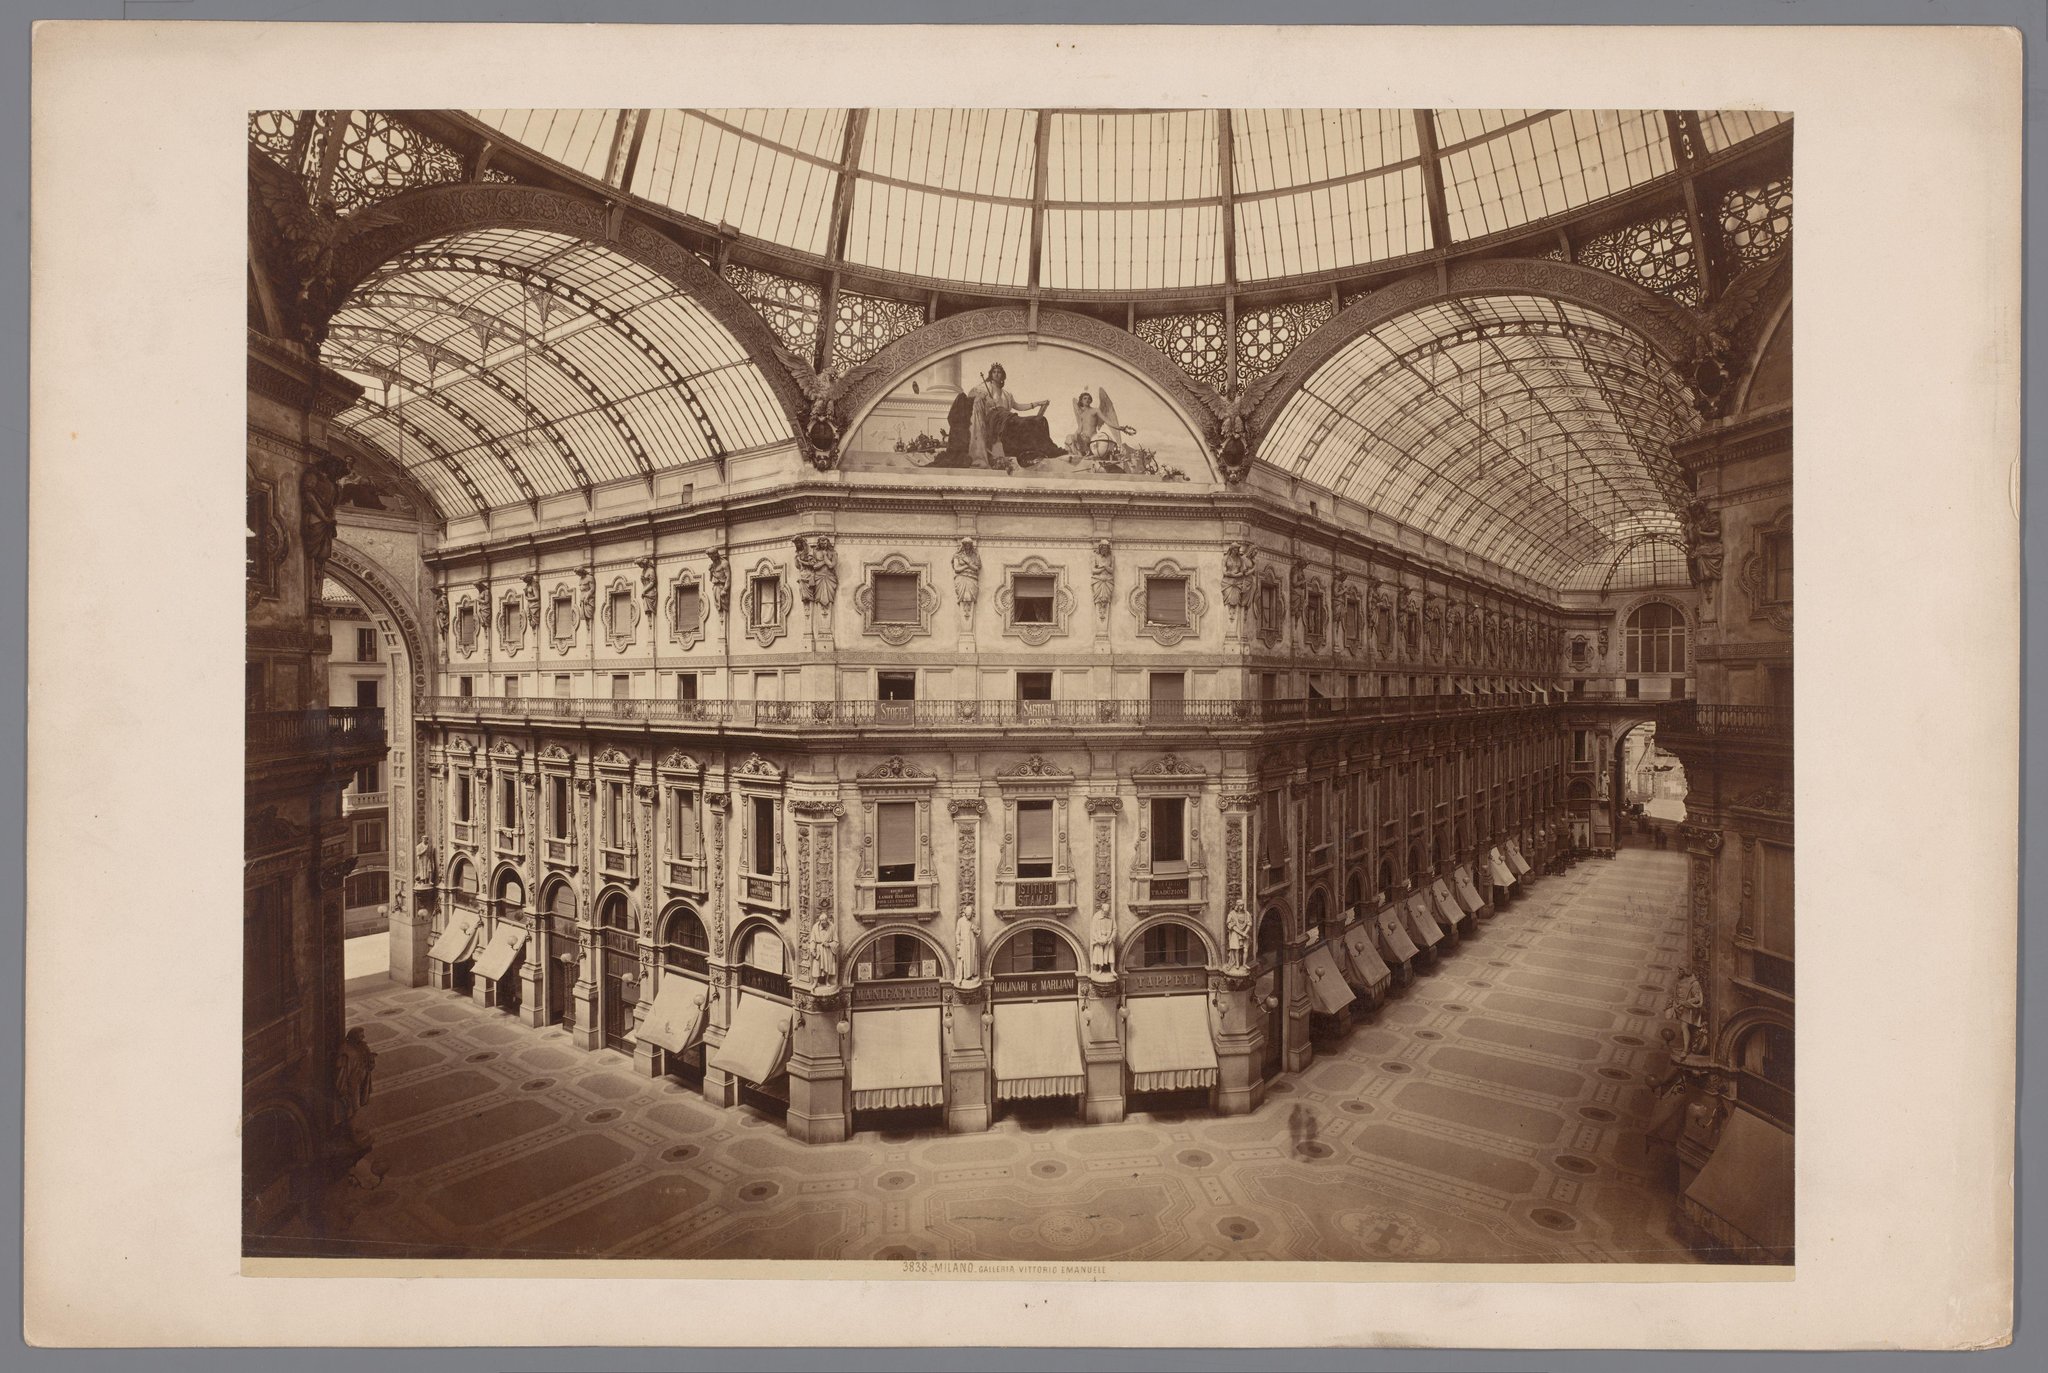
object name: photograph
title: Galleria Vittorio Emanuele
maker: Anonymous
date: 1878-1900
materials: cardboard, paper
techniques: albumen print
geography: milan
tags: passage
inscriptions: number: ‘3838.’, collector's mark: ‘RIJKS SCHOOL VOOR KUNSTNIJVERHEID/ GROEP’, inscription: ‘pl 10’